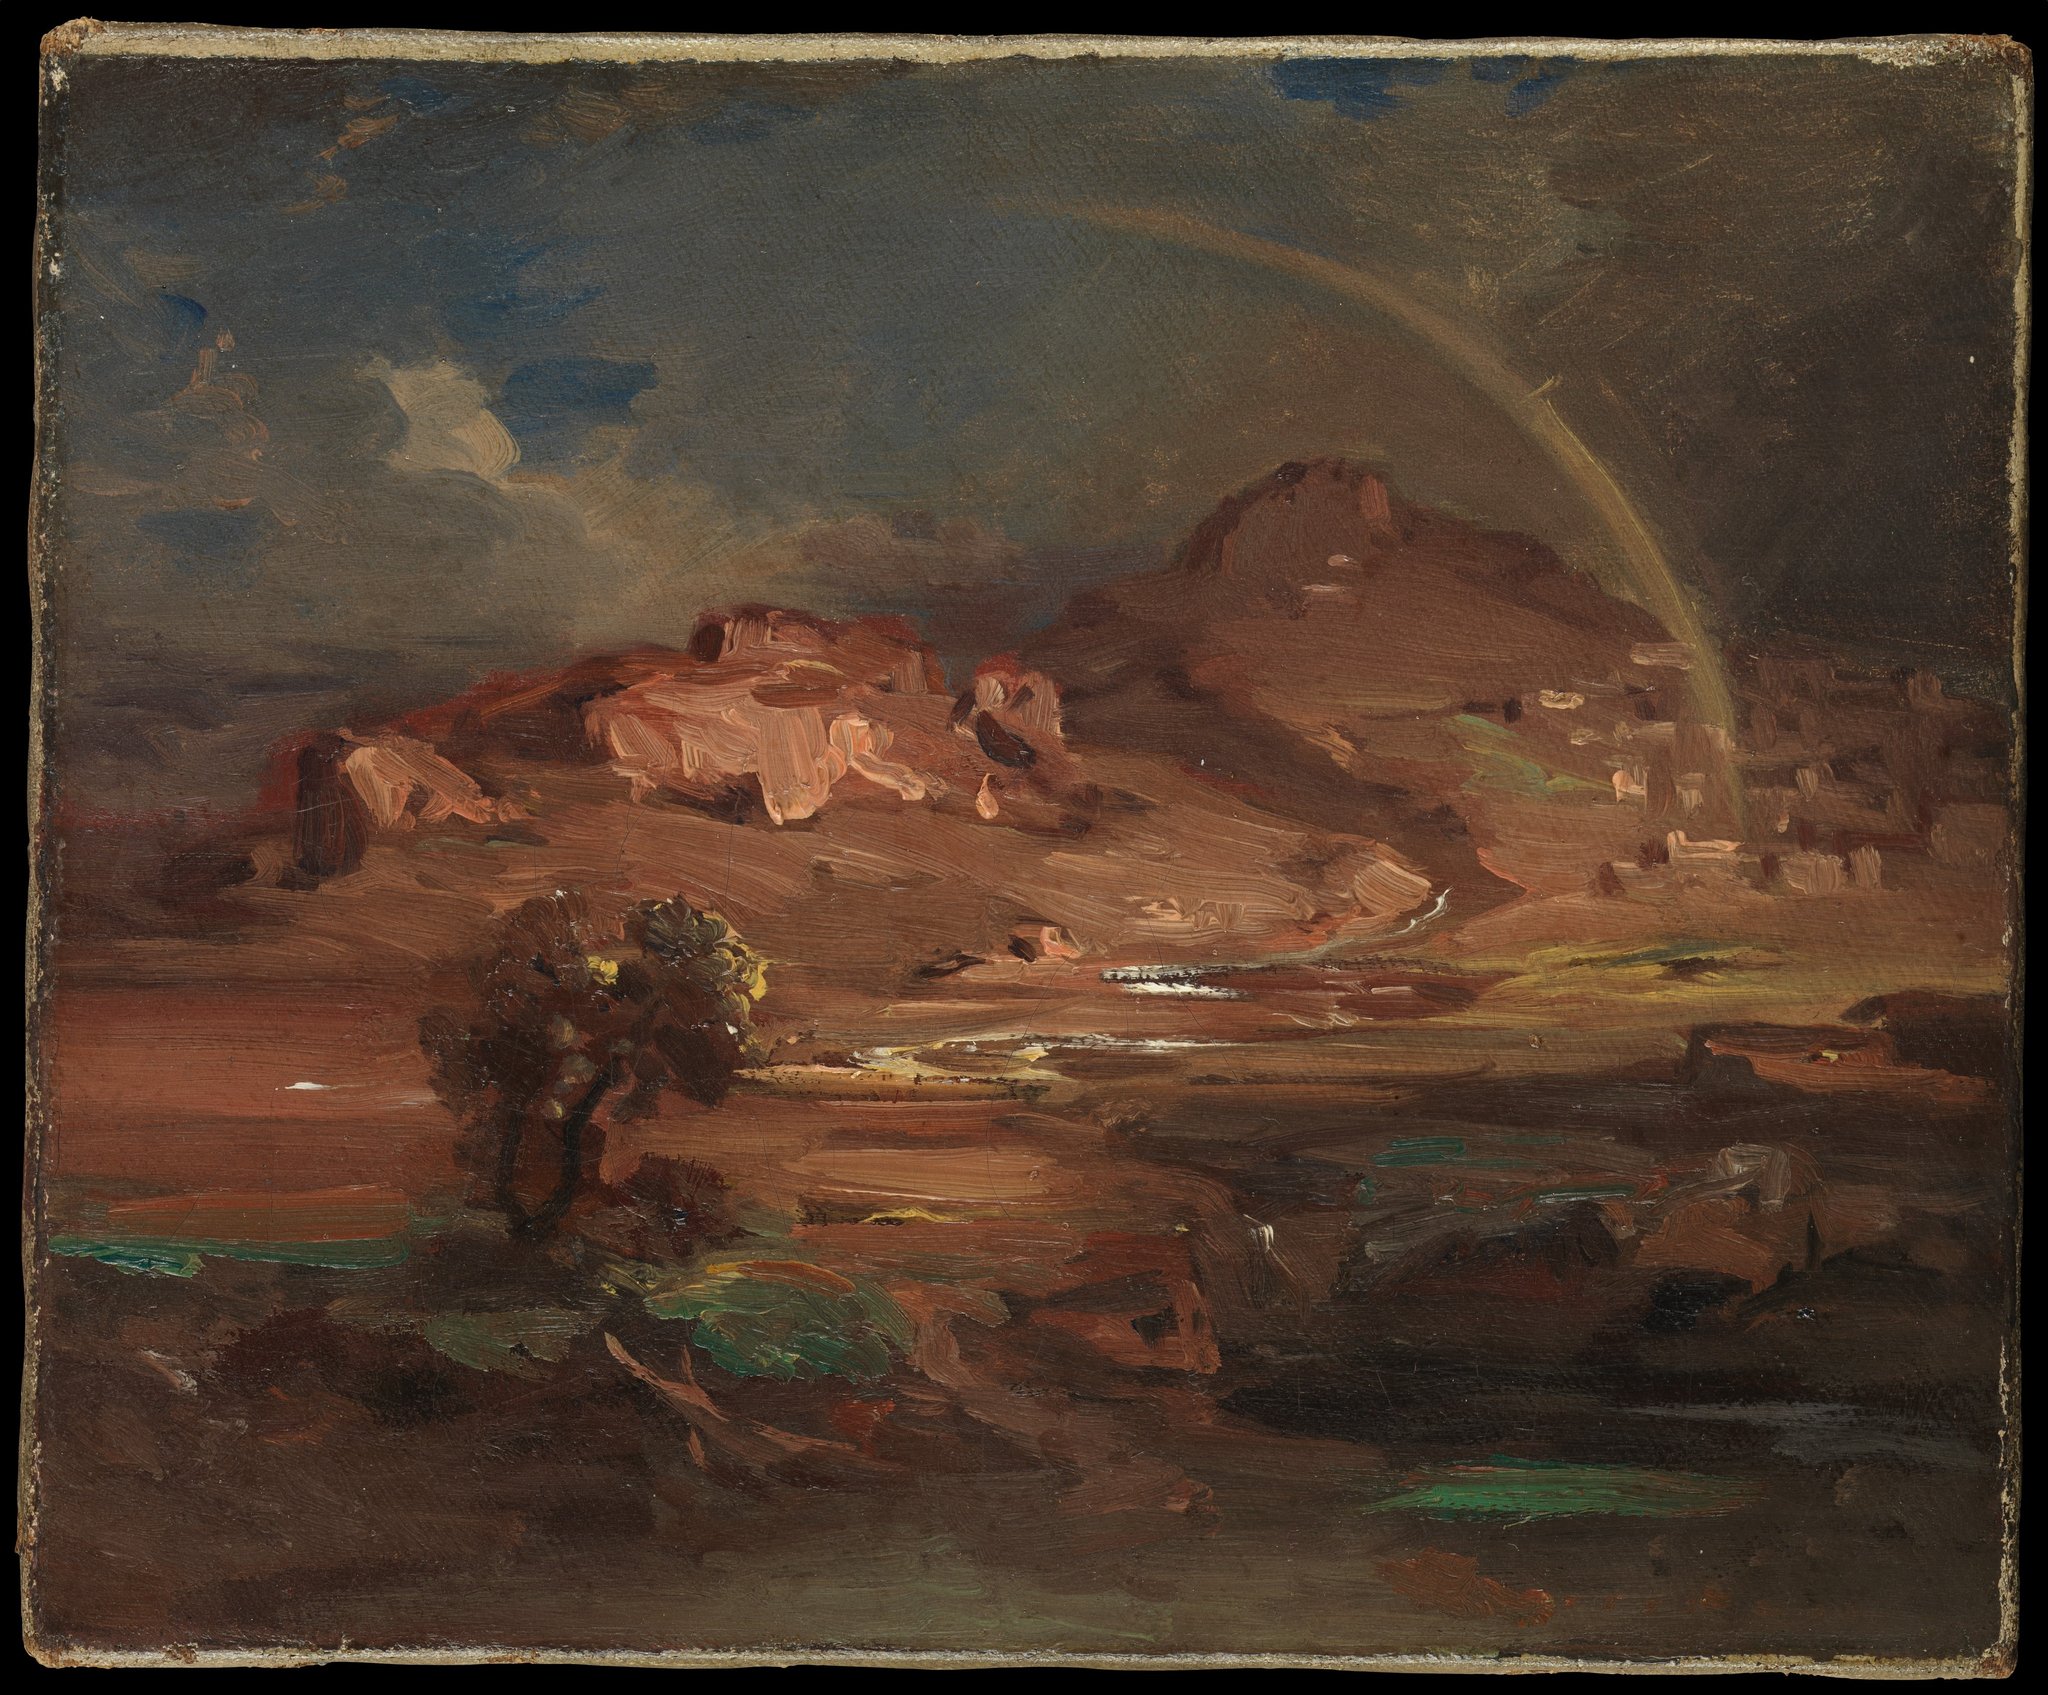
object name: painting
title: The Cemetery at Pronoia near Nauplia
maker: carl rottmann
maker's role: artist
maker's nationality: german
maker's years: 1797-1850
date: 1841-1847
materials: canvas, oil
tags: cemeteries